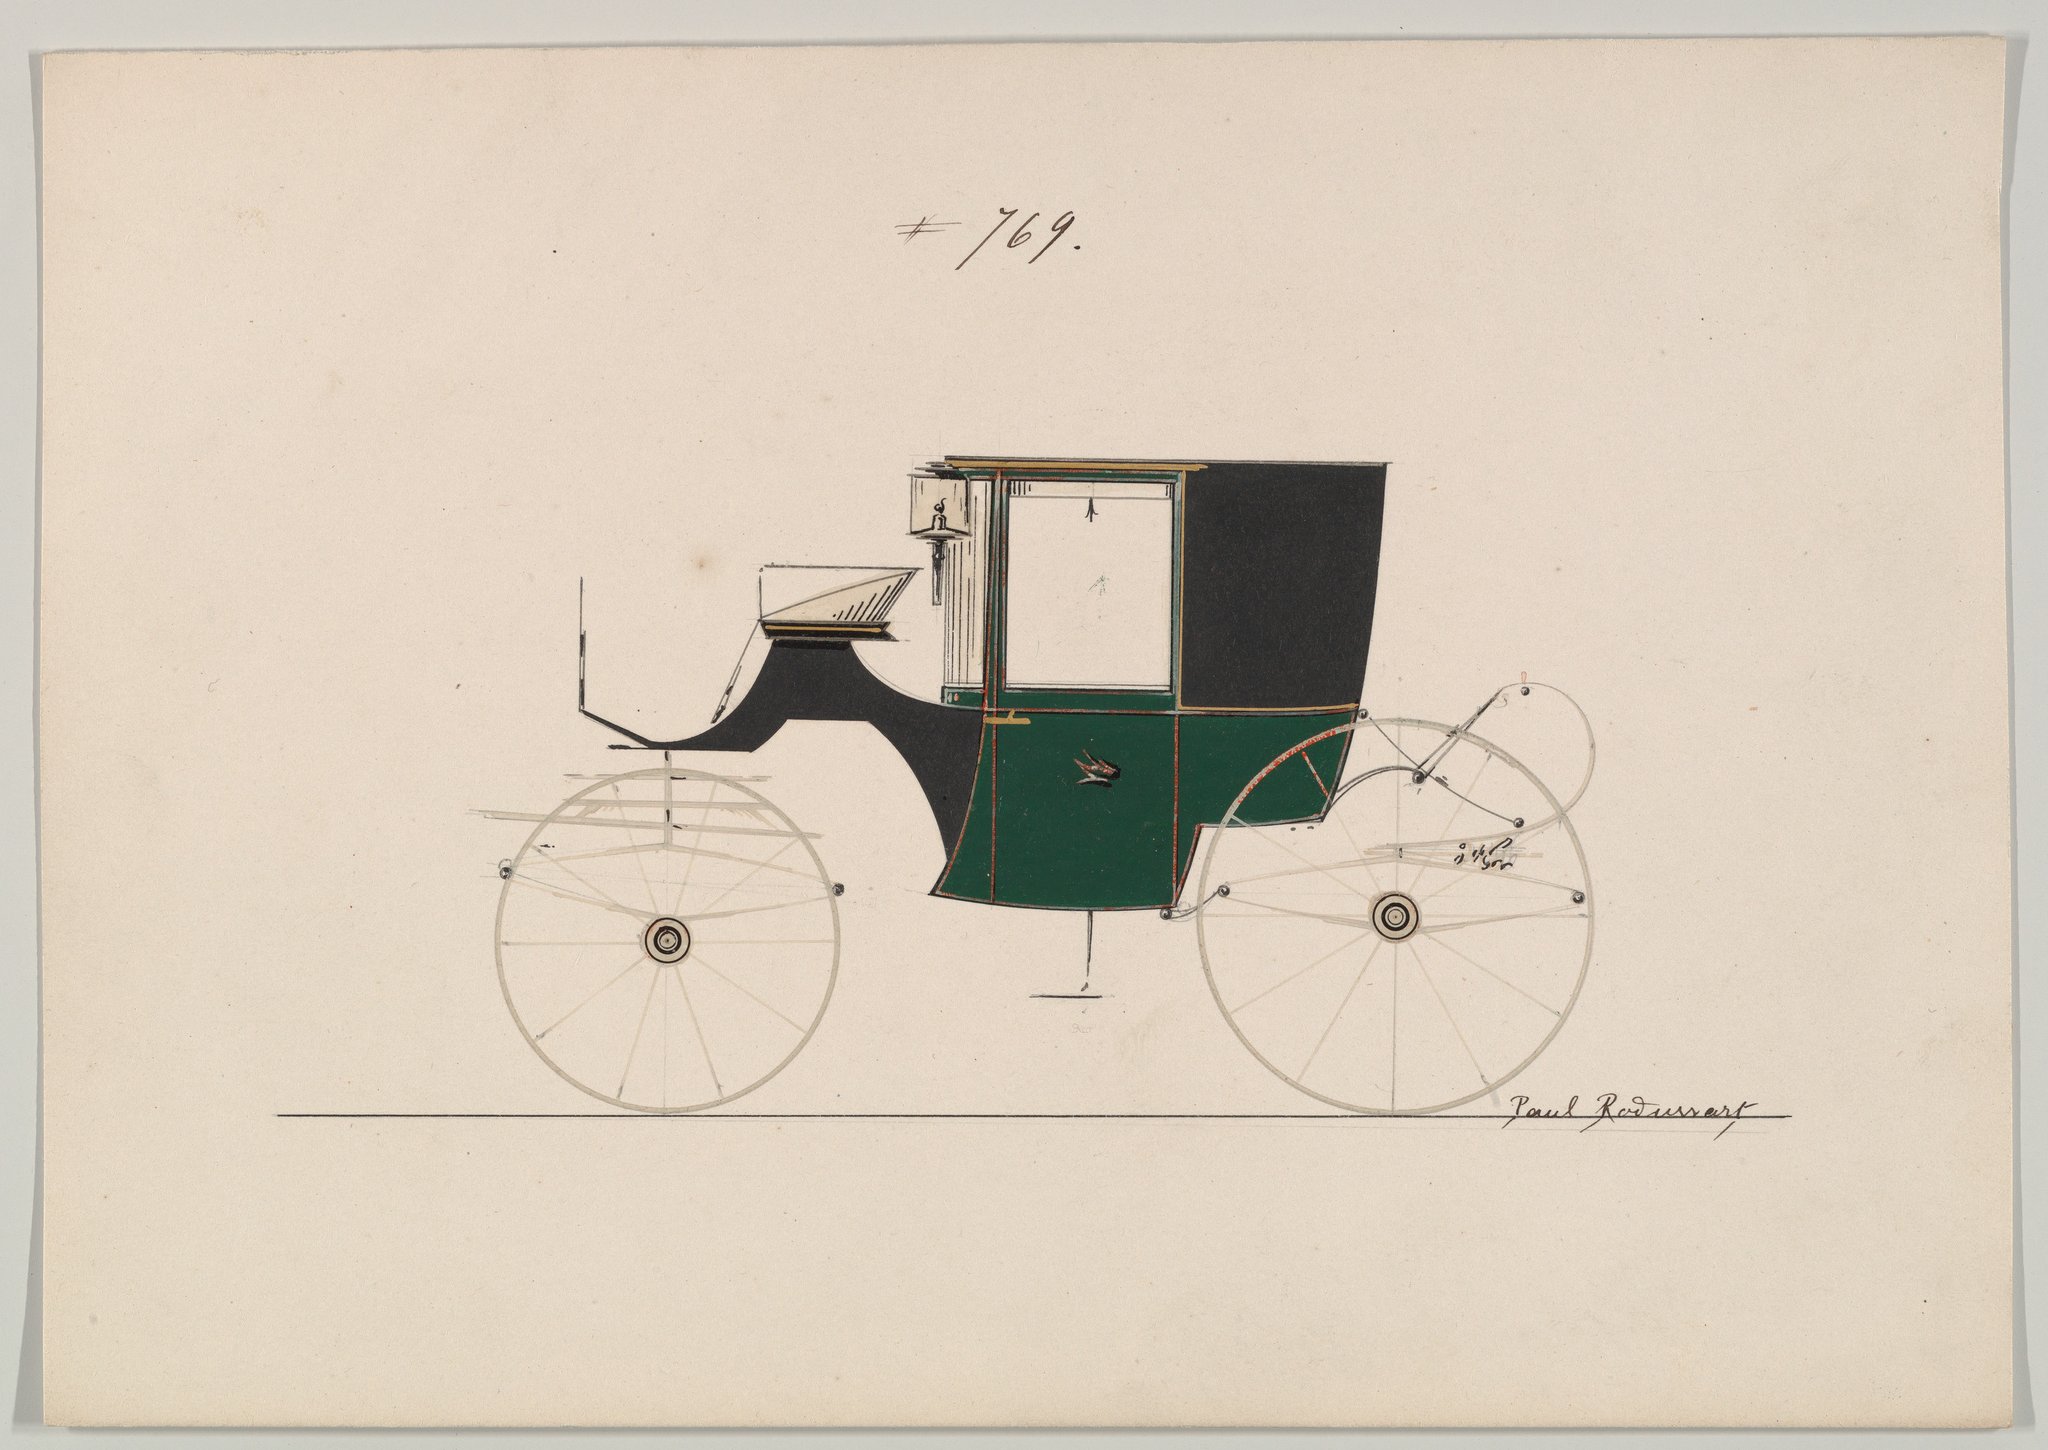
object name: drawing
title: Coupé # 769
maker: brewster & co.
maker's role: manufacturer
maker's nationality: american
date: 1850-1870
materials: gouache, gum arabic, ink, watercolor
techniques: pen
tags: carriages